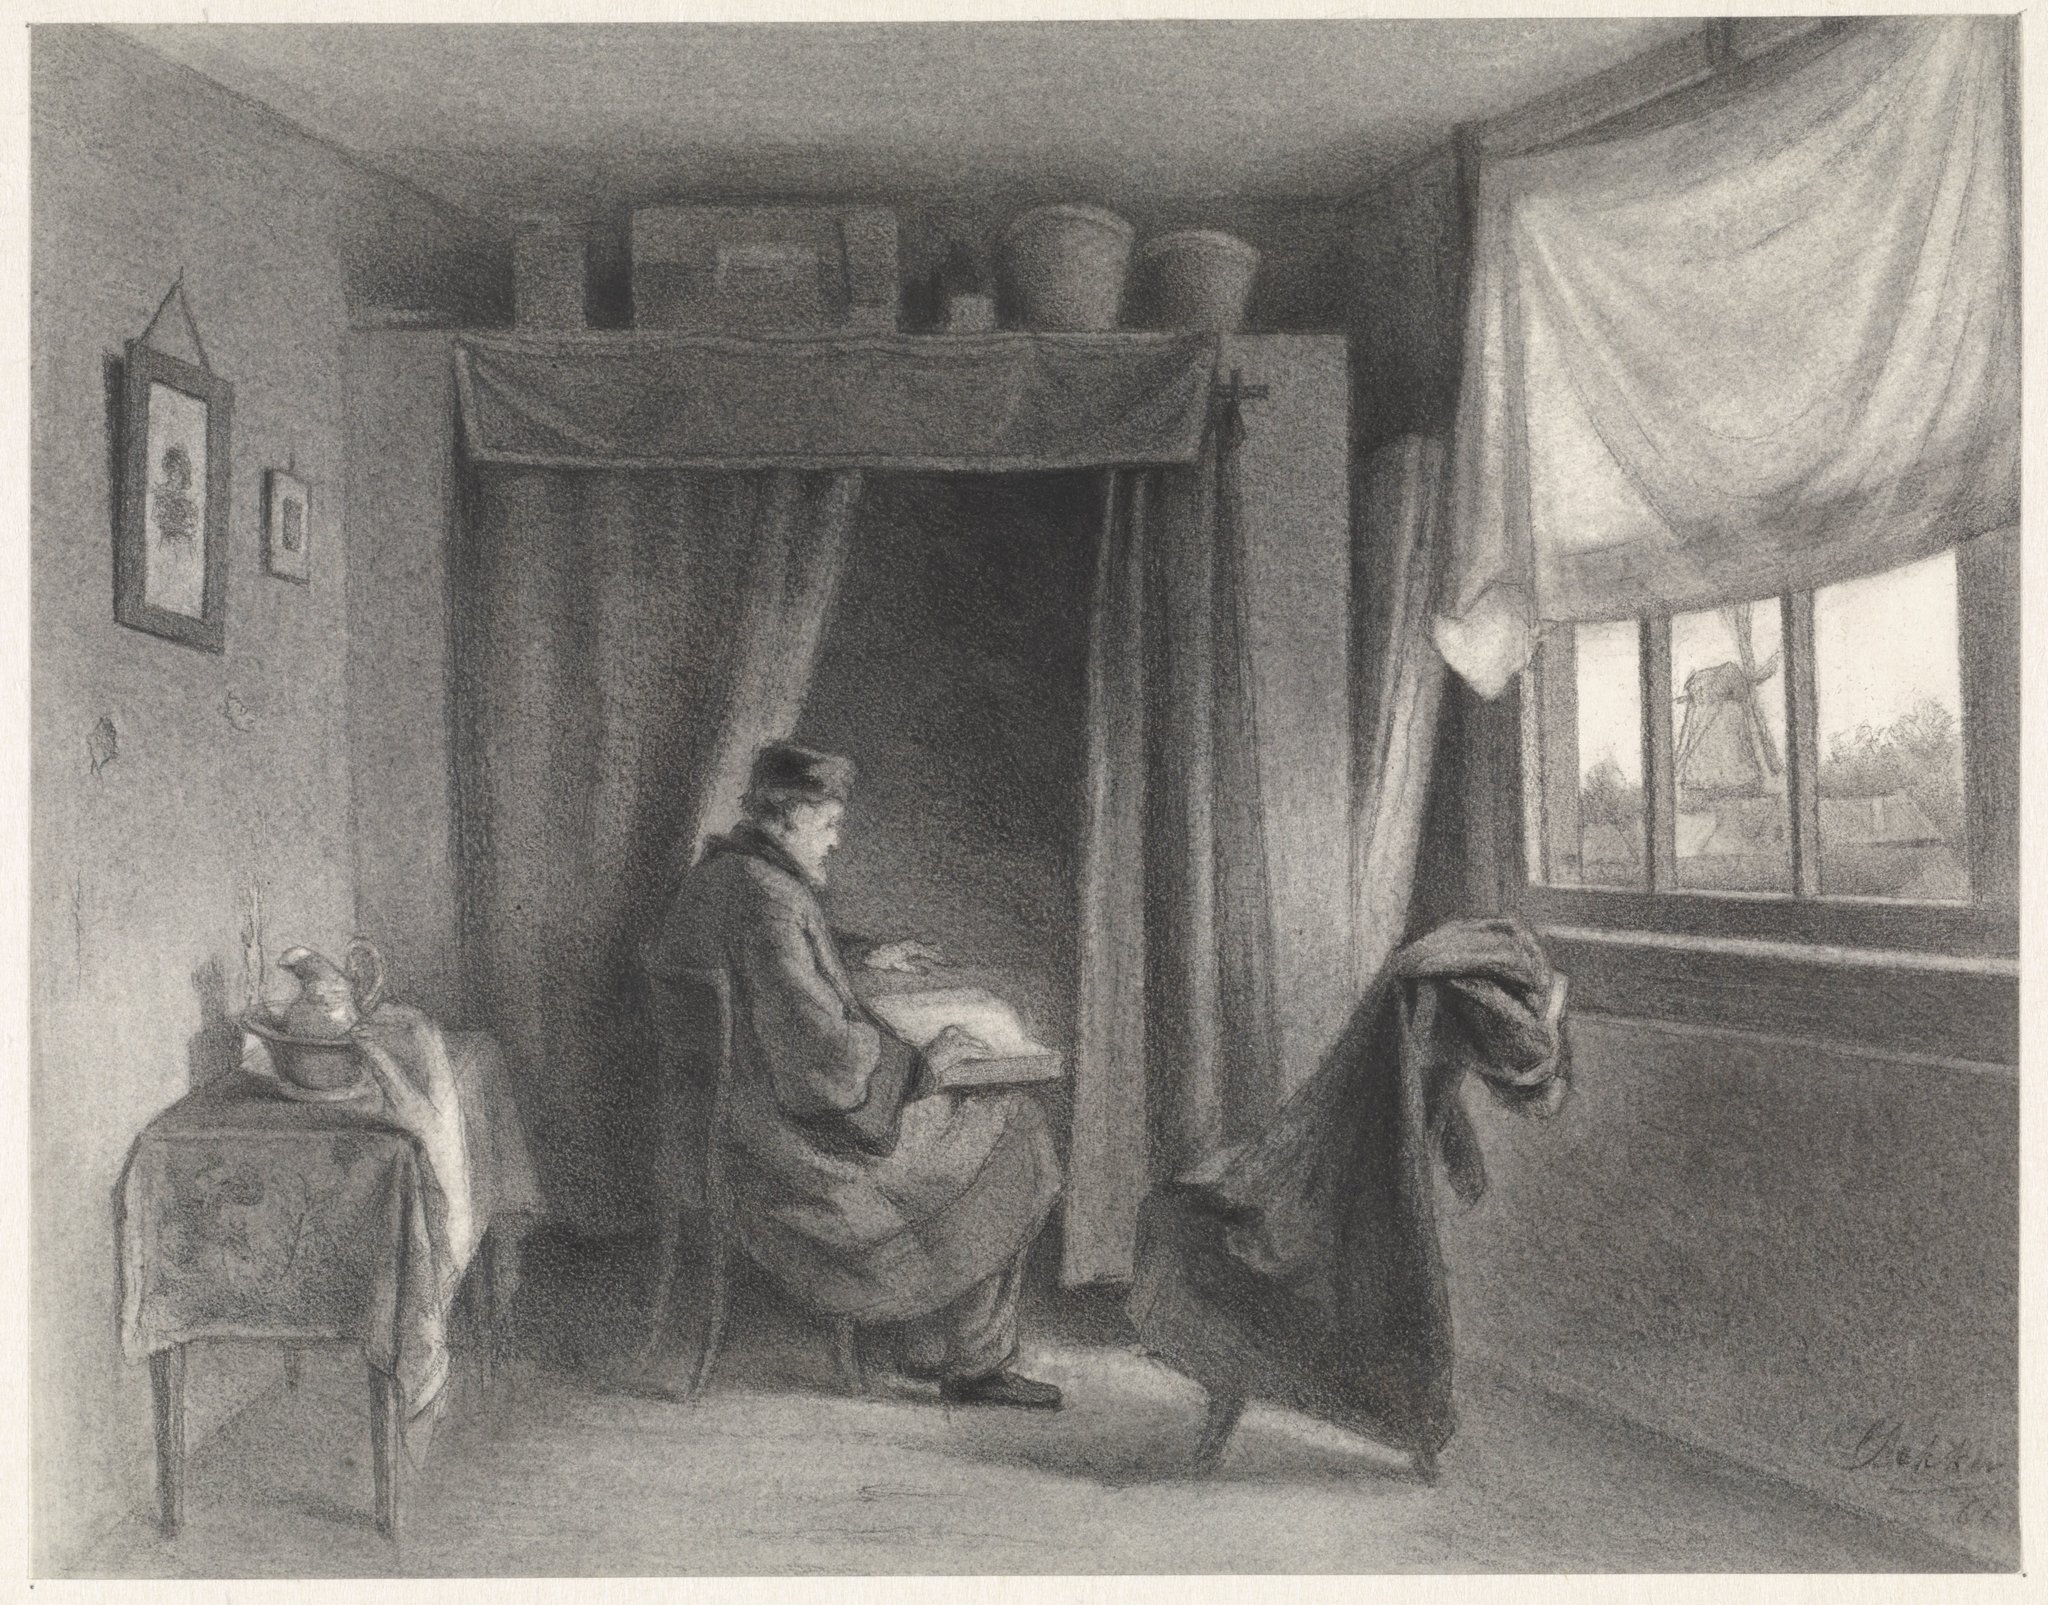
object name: drawing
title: Interieur met man die voorleest aan een zieke in bed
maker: hendrik adriaan christiaan dekker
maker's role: draughtsman, print maker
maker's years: 1836-1905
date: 1846-1905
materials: chalk, paper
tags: reading to somebody, visiting the sick; sick person together with others, bedroom